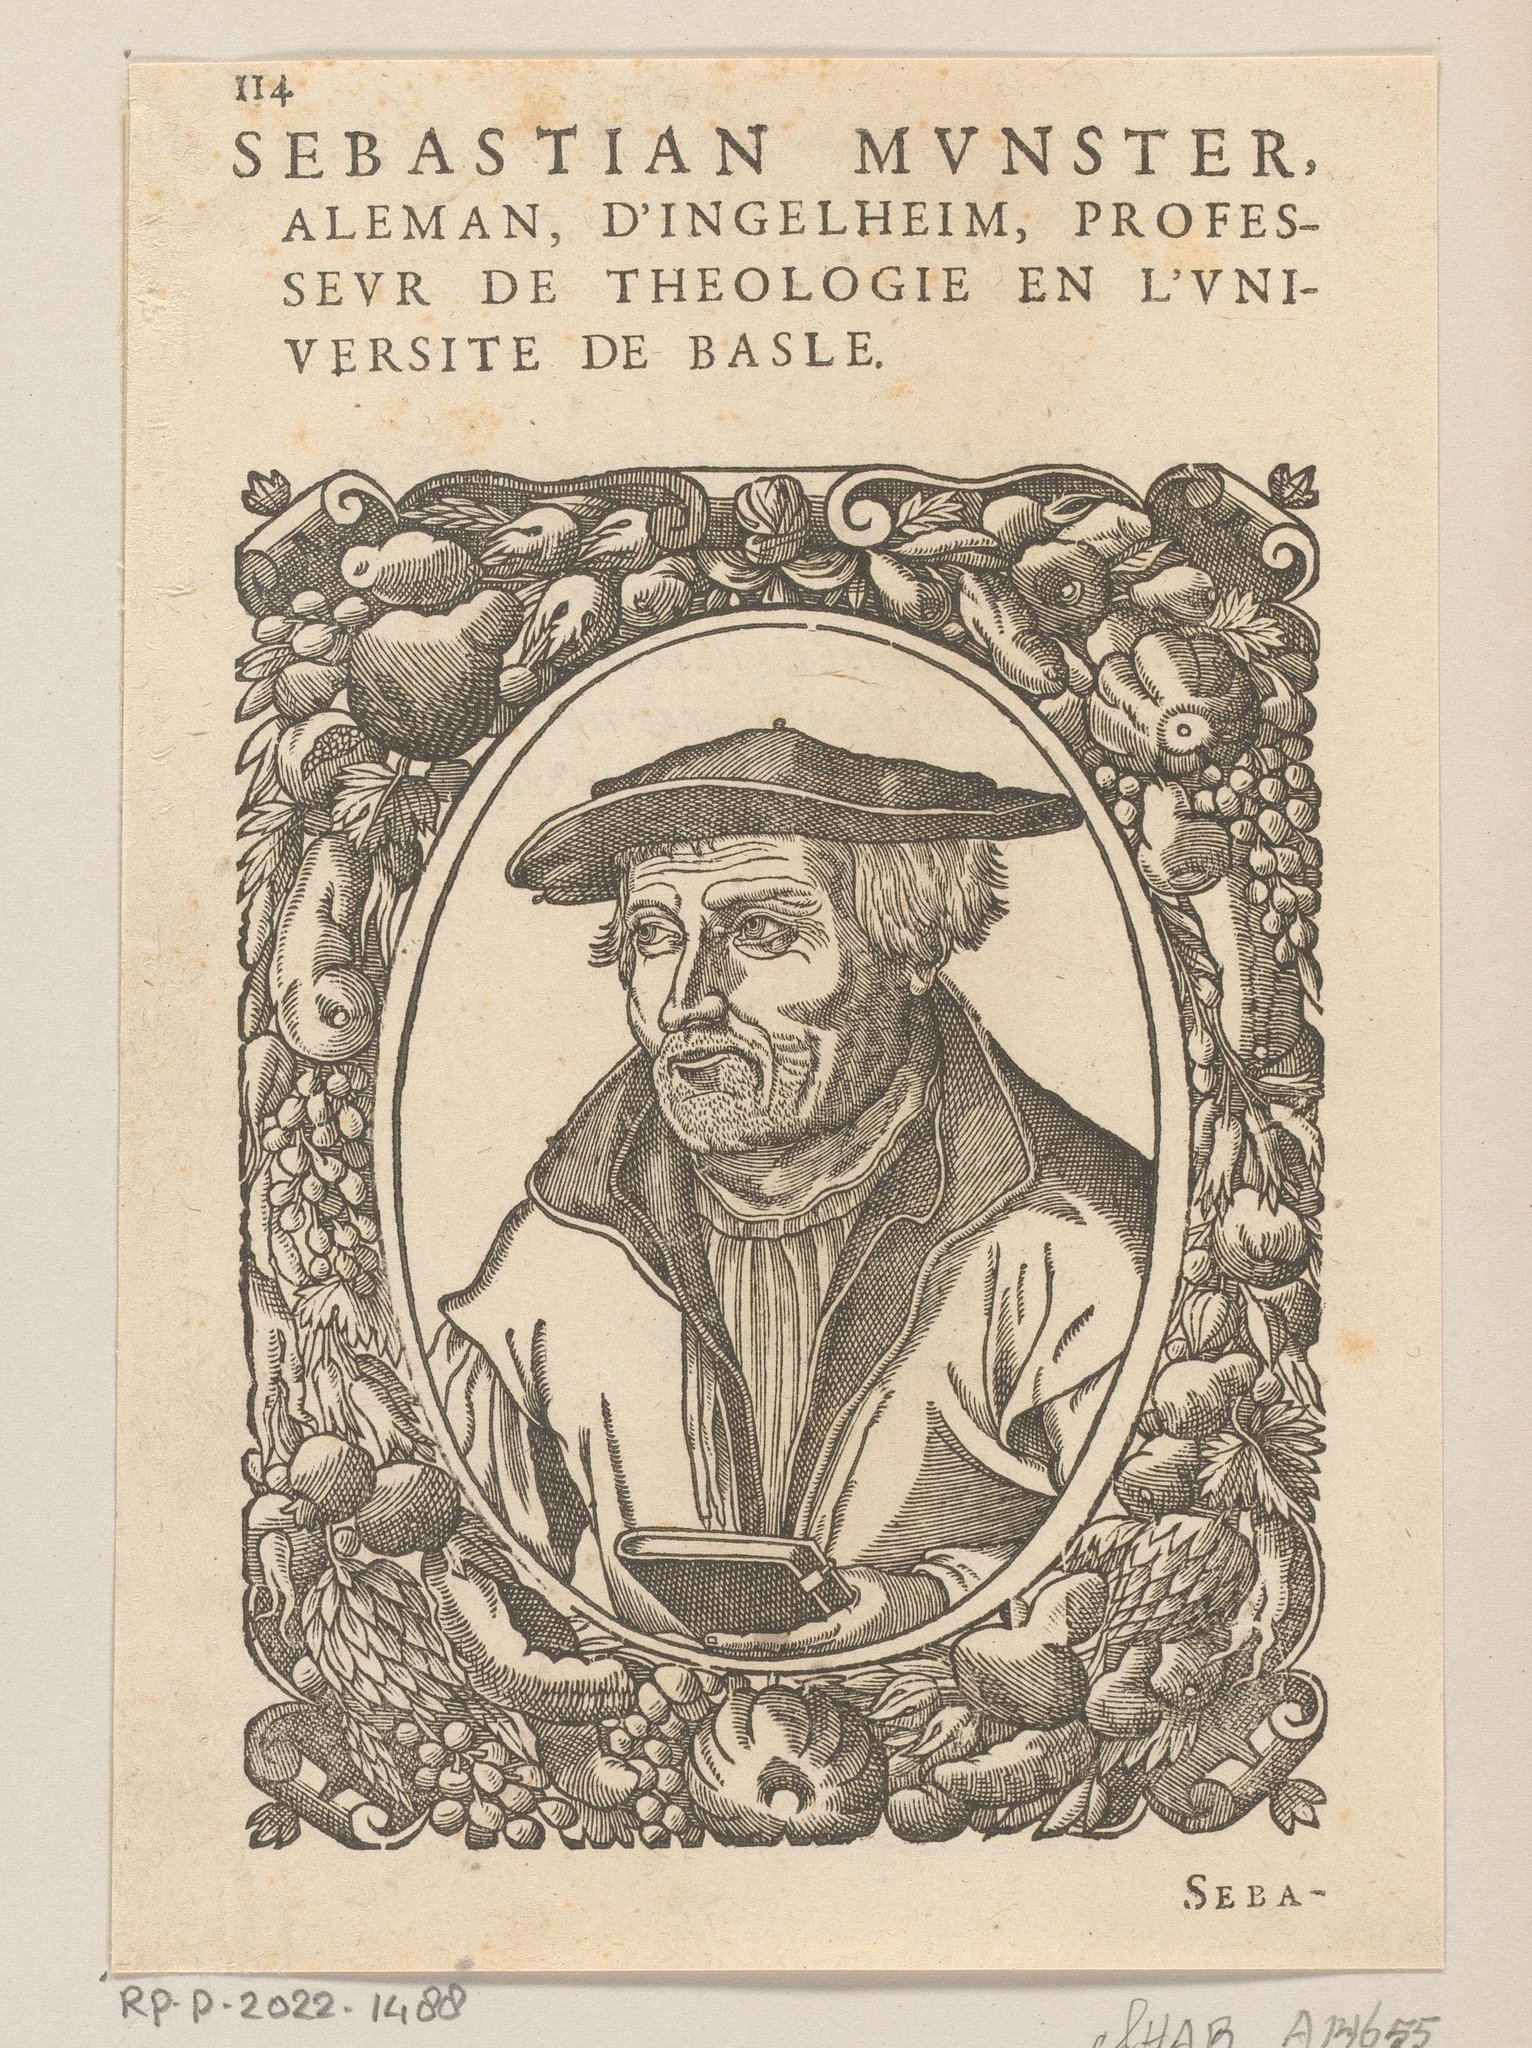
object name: book illustration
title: Sebastian Munster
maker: Anonymous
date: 1540-1650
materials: paper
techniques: letterpress printing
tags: scholar, philosopher, historical persons